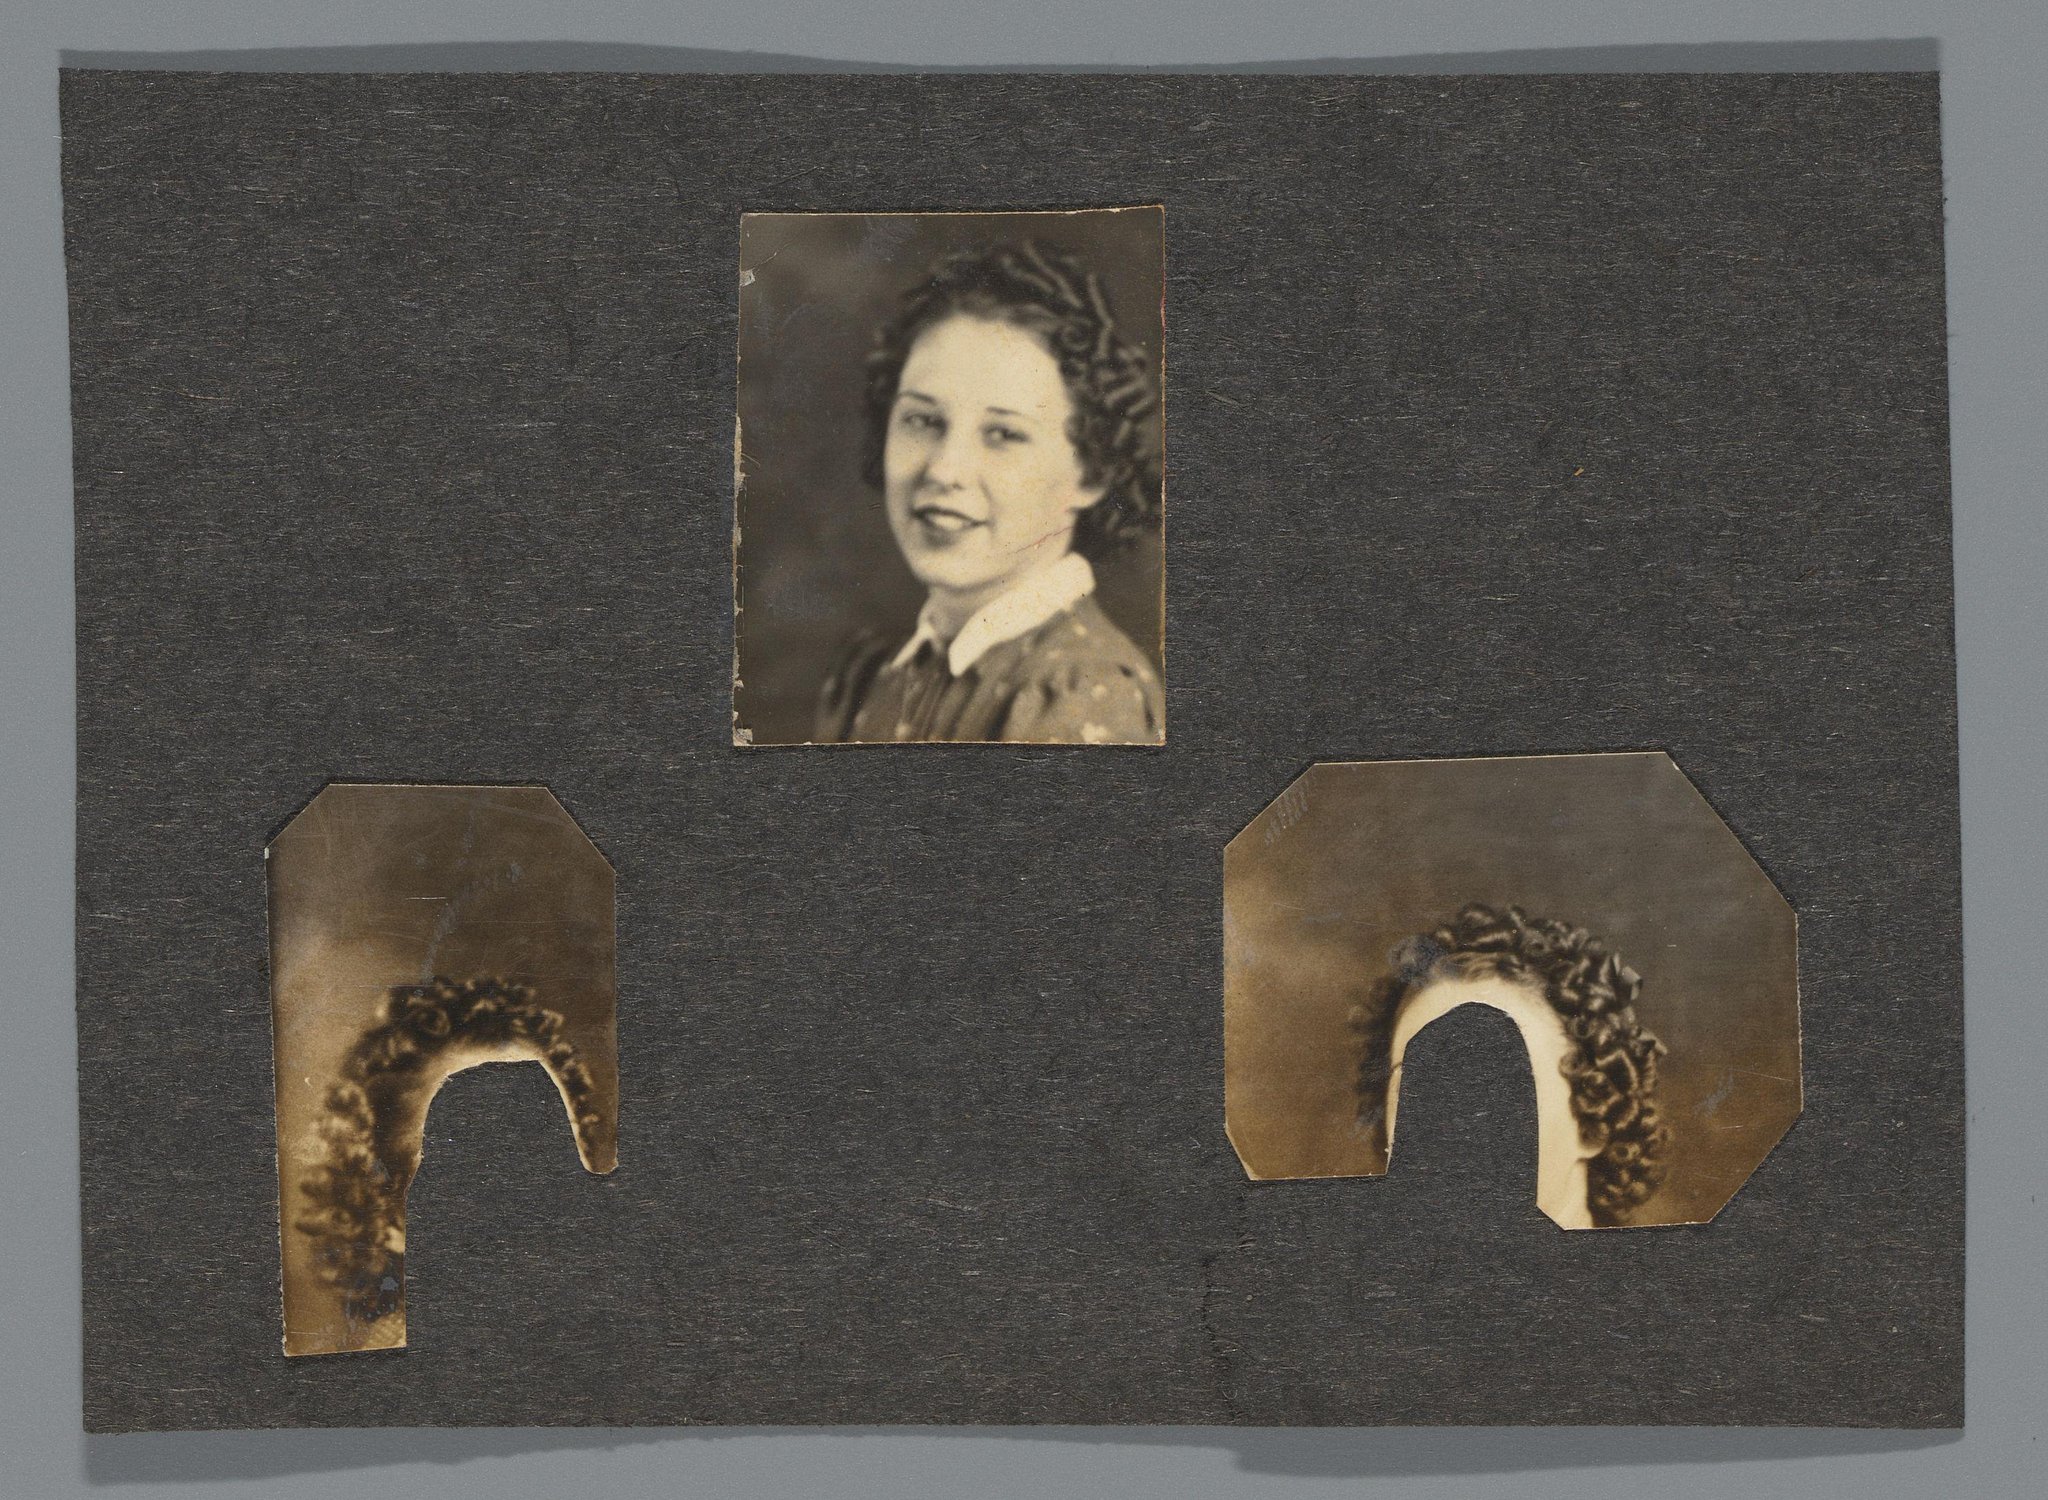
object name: album leaf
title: Albumblad met drie portretten van een vrouw, waarbij op twee het gezicht is weggeknipt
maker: Anonymous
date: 1920-1930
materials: paper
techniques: gelatin silver print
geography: united states